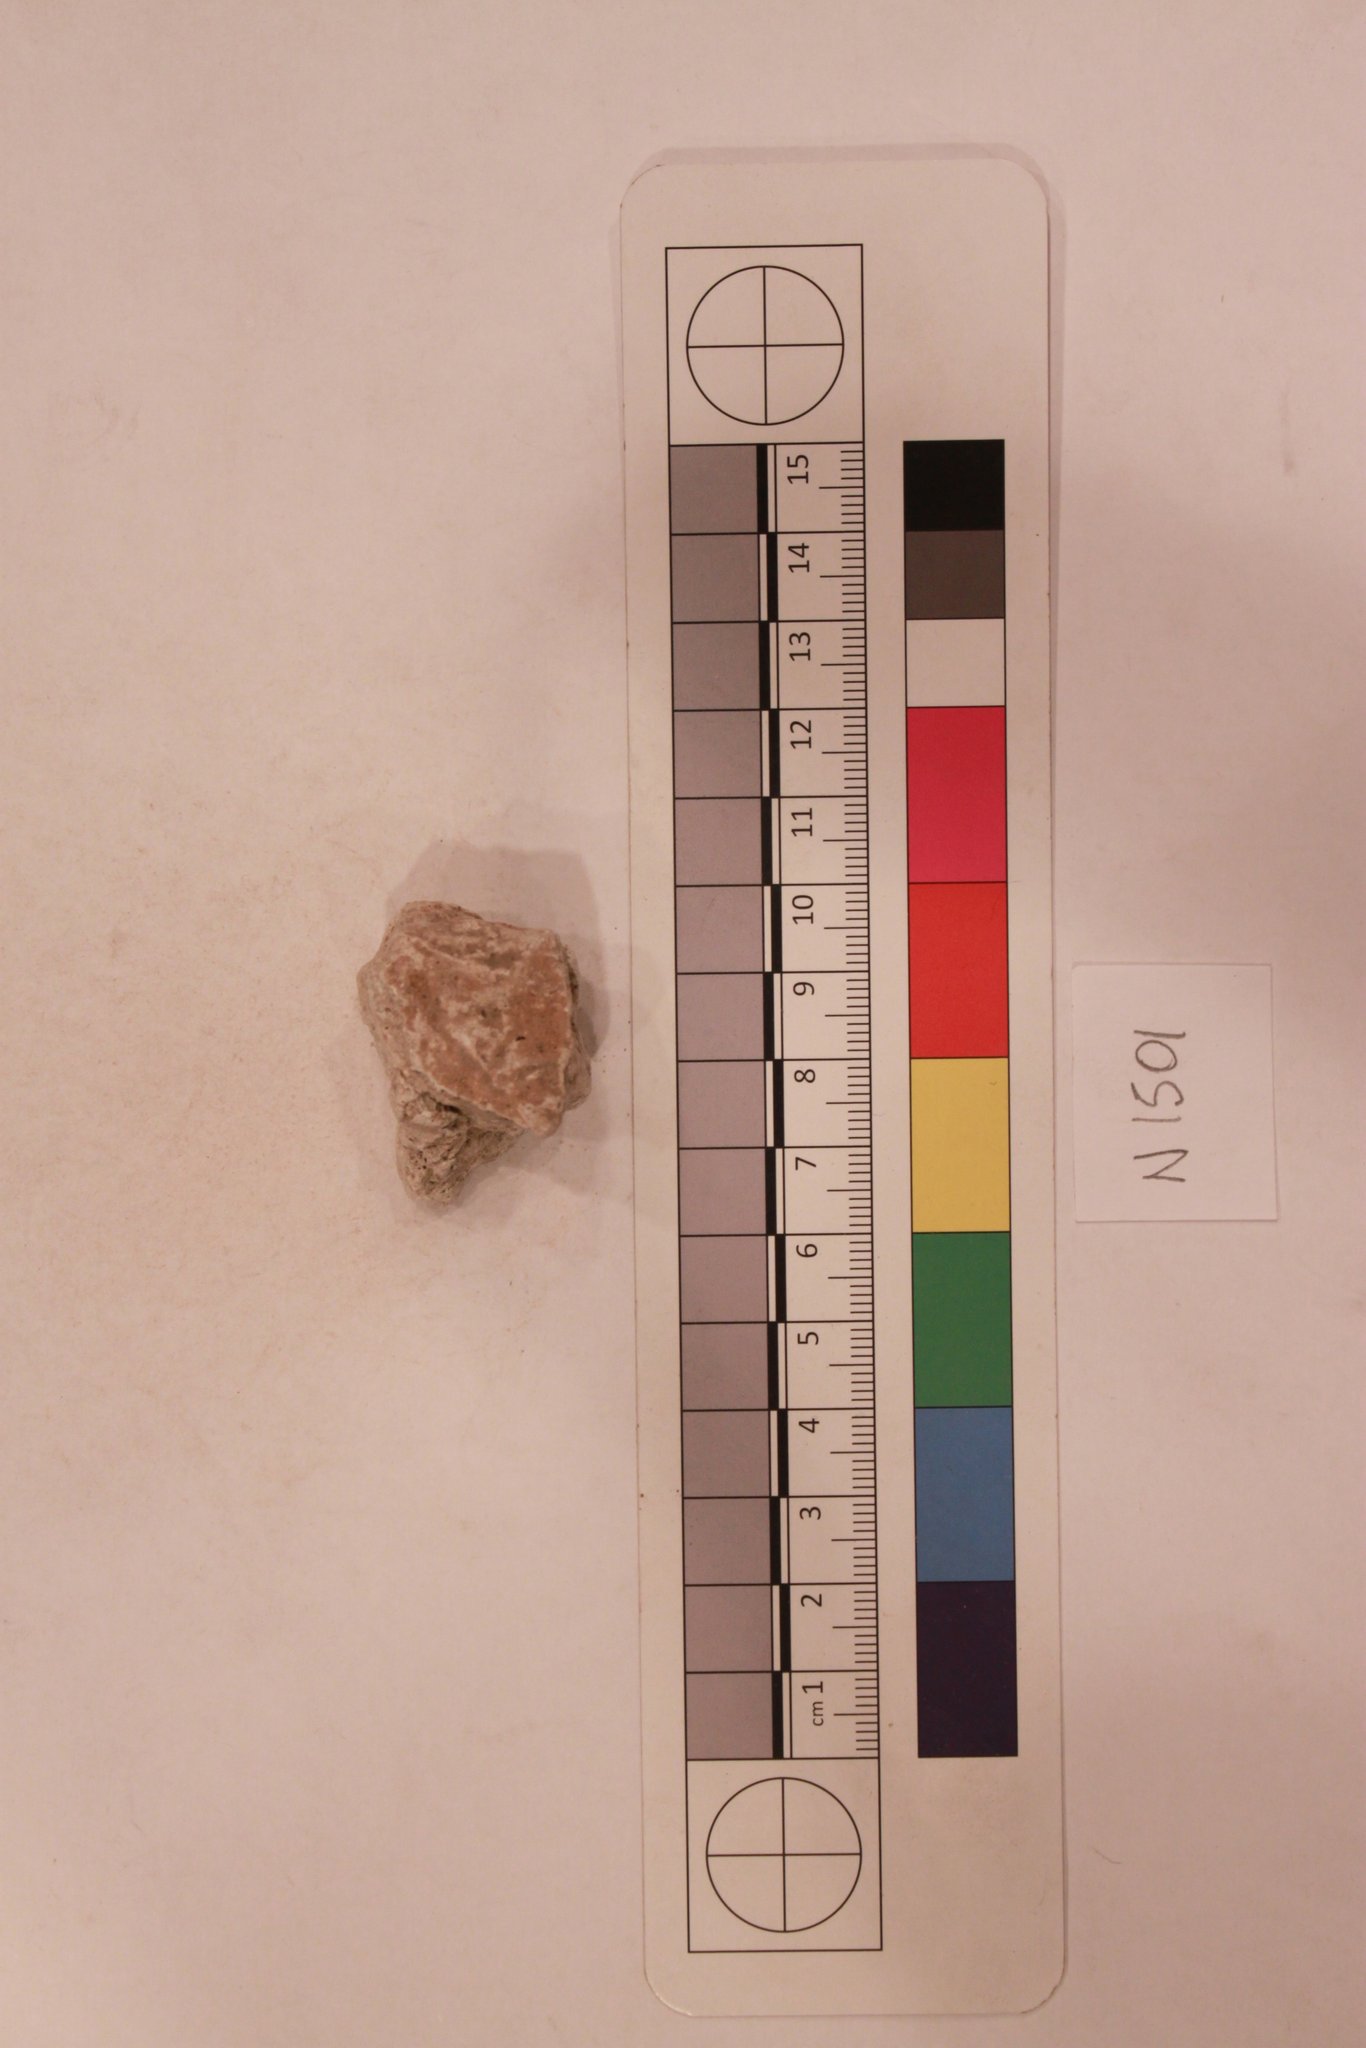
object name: fragment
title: Stucco Fragment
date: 701-1200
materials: plaster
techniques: carving, painting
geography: iran